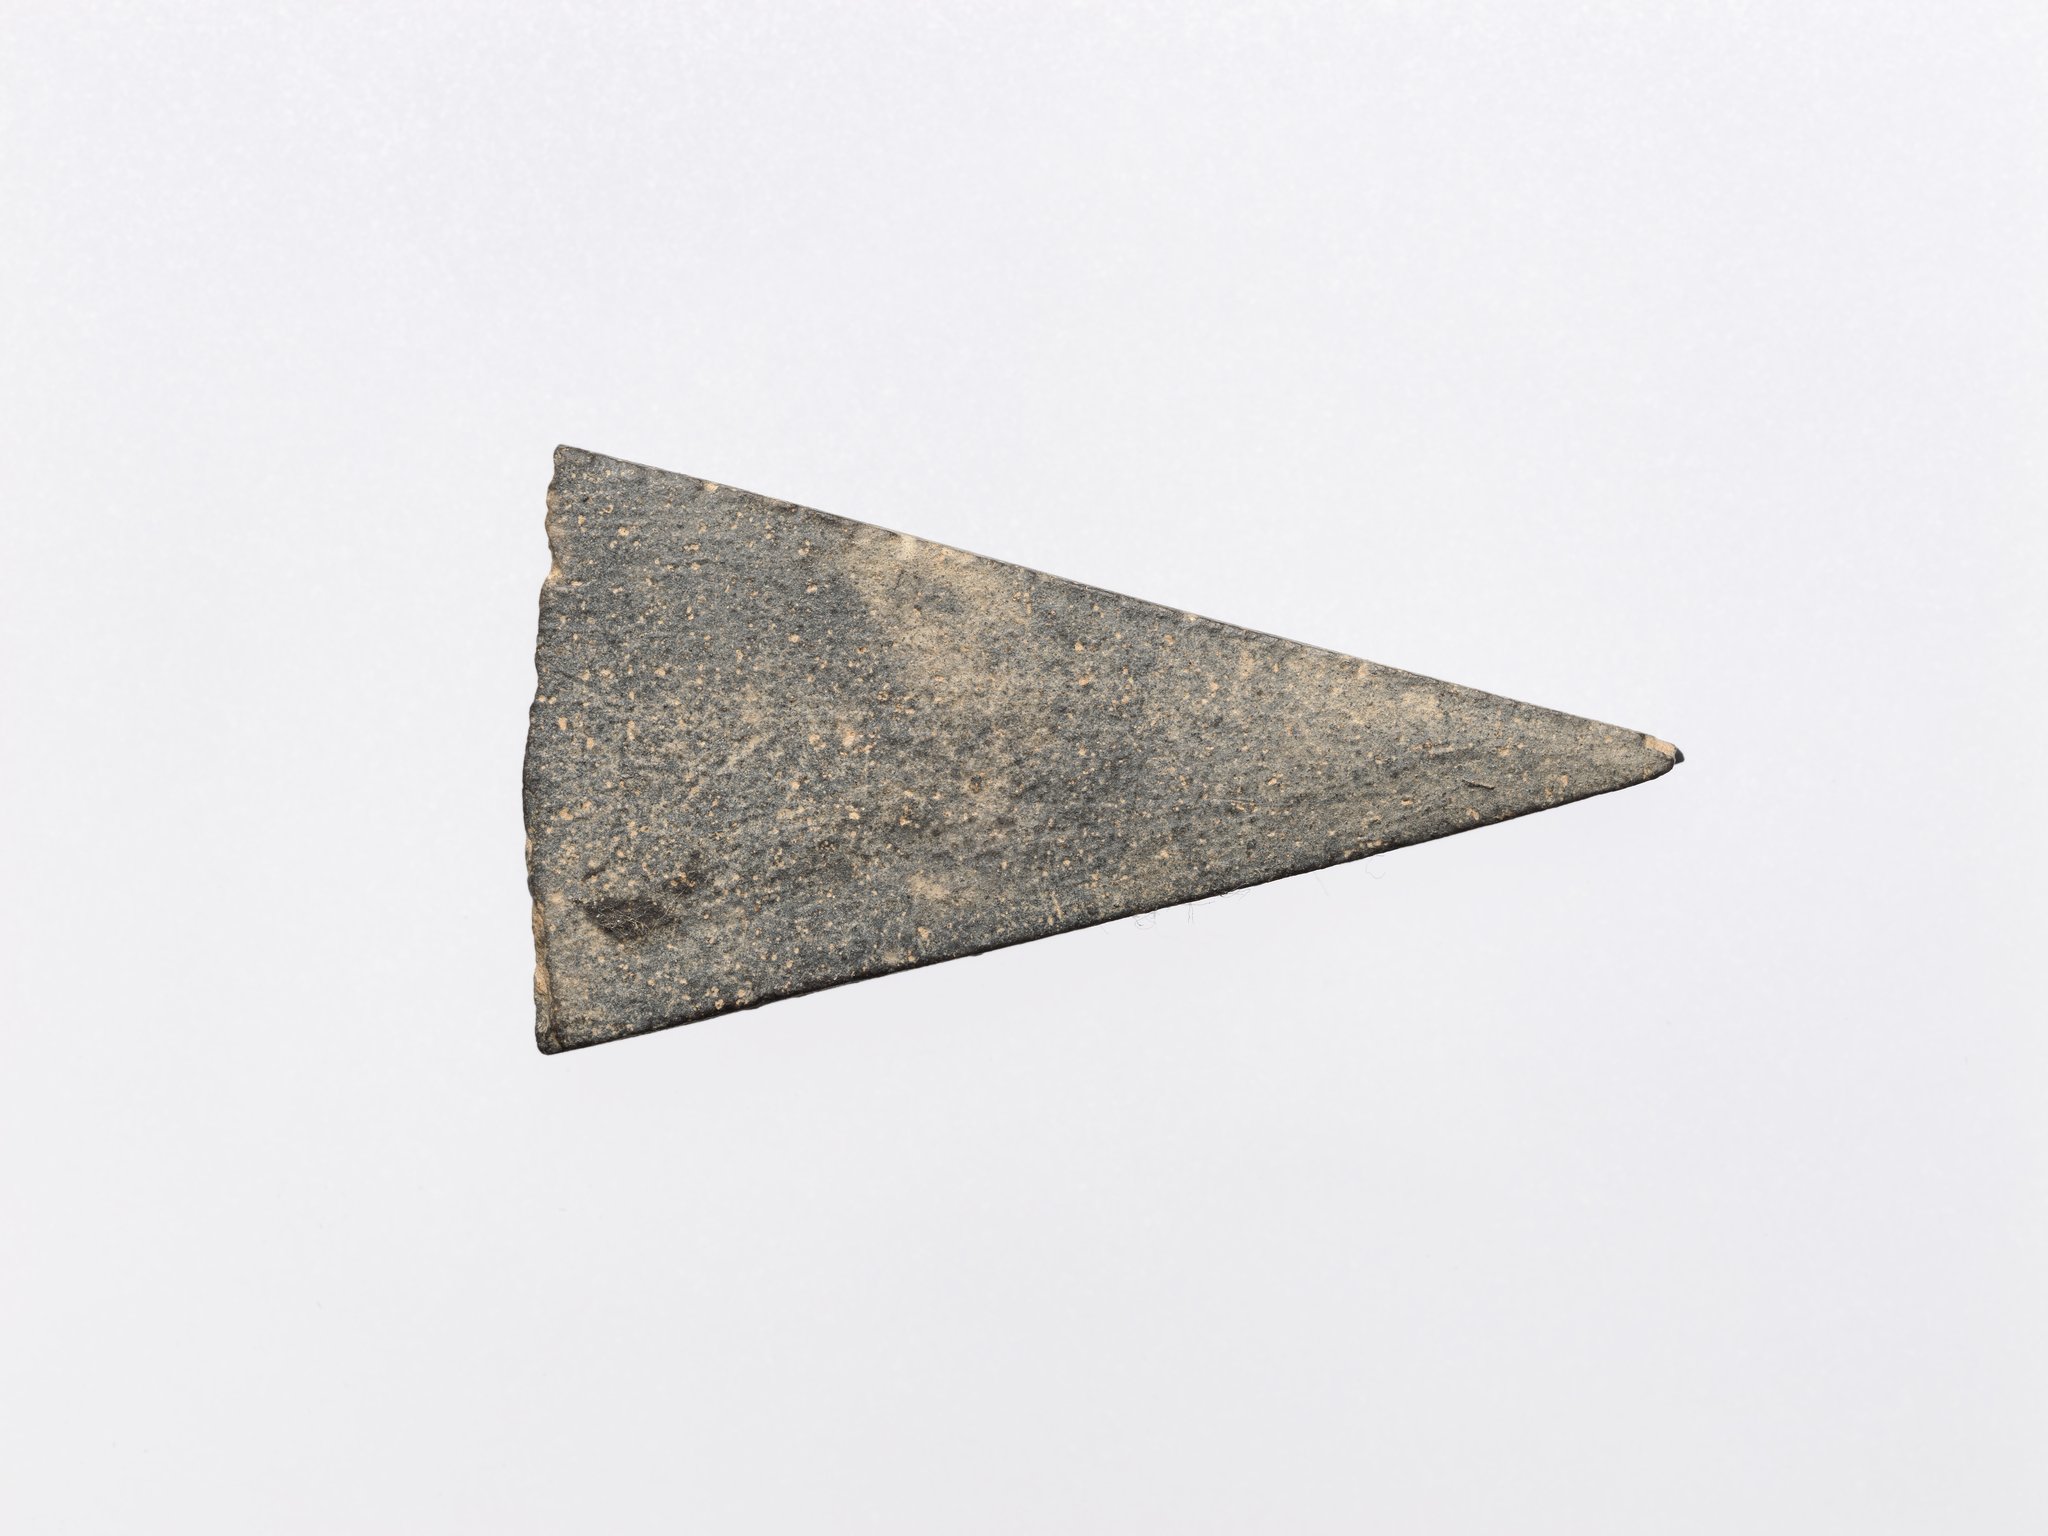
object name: inlay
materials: stone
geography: mesopotamia